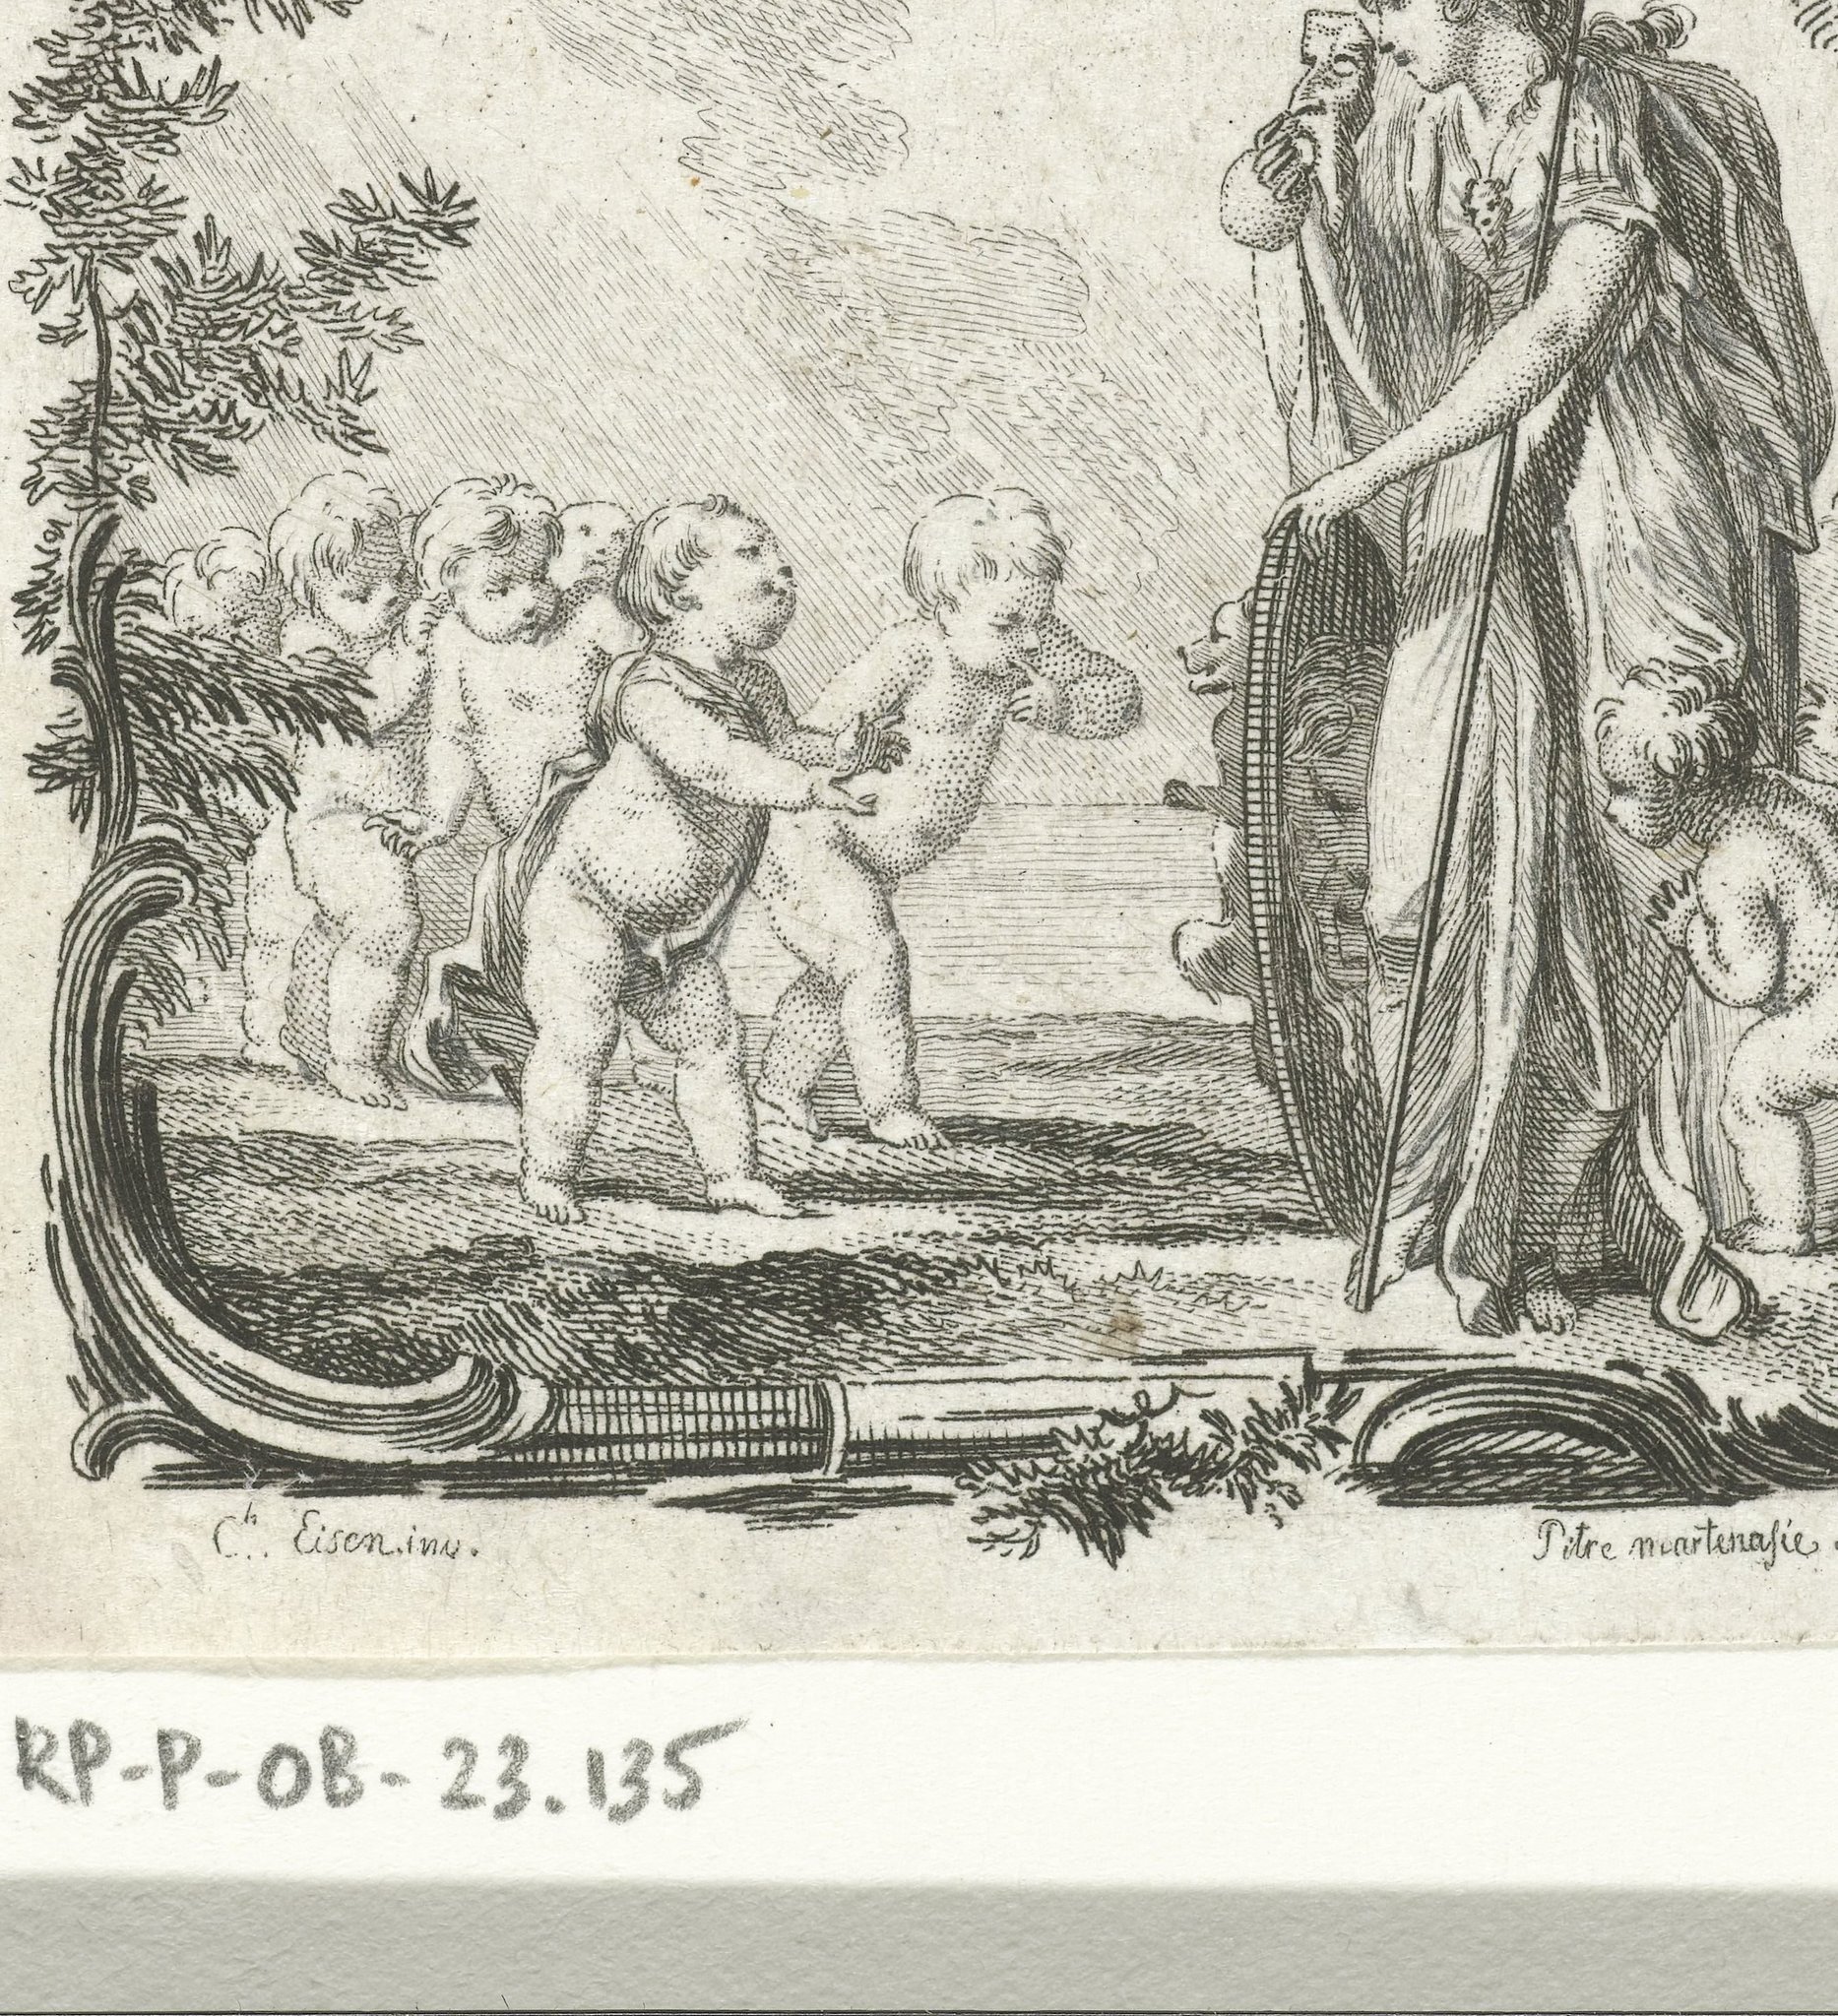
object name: print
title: Minerva en putti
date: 1739-1789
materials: paper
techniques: etching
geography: antwerp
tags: (story of) minerva (pallas, athena), cupids: 'amores', 'amoretti', 'putti'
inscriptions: collector's mark: Lugt 2228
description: Minerva met speer, helm en schild, houdt een masker in haar hand, temidden van vele putti.